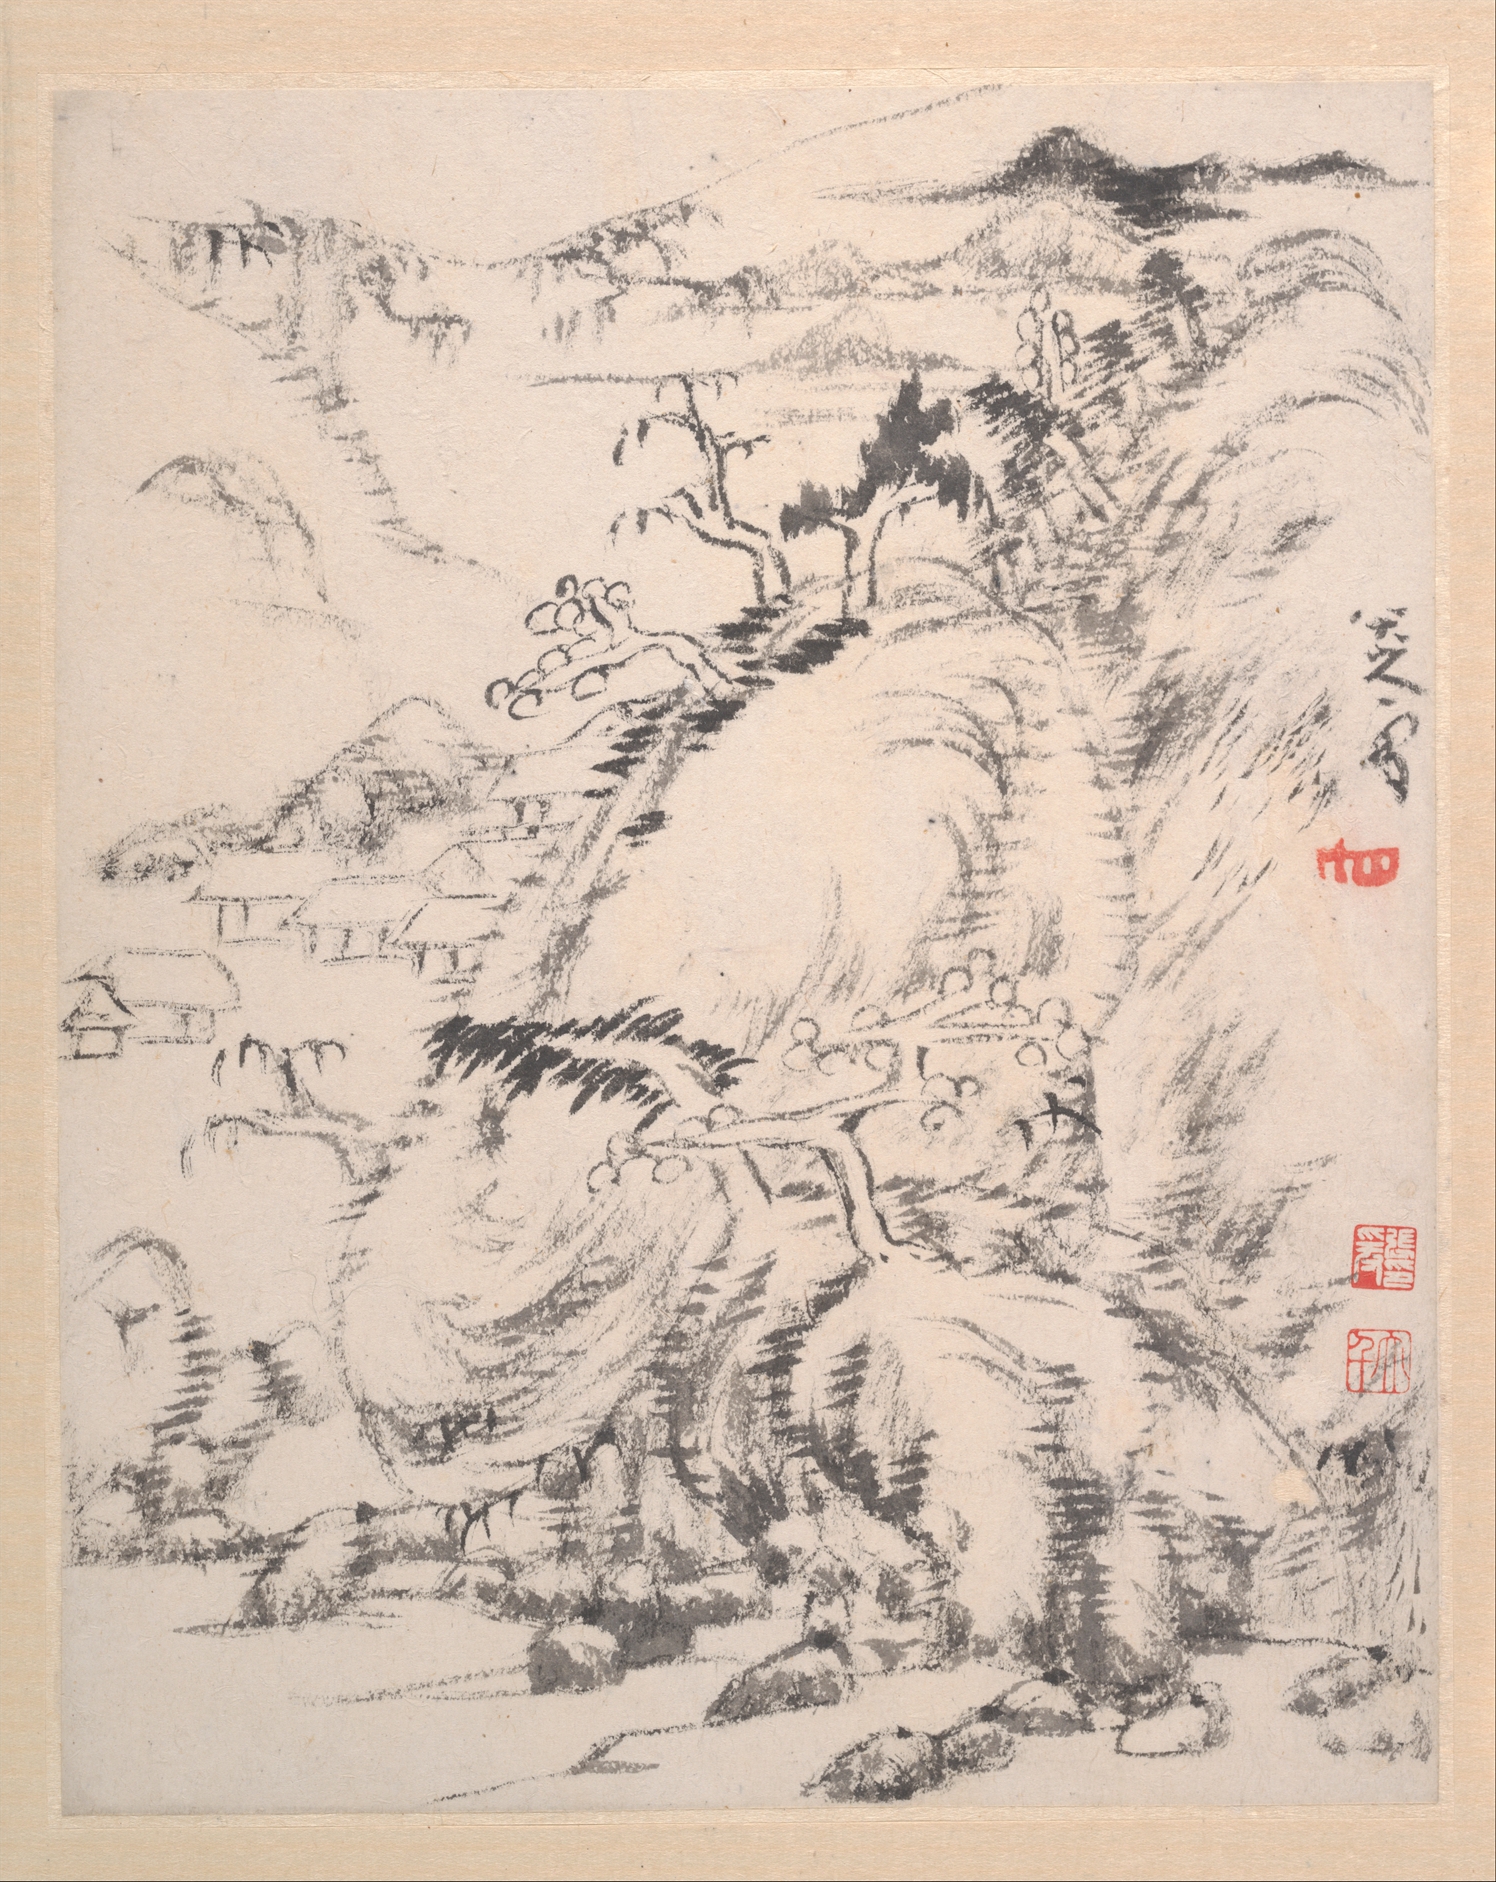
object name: album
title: Landscape album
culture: chinese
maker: bada shanren (zhu da)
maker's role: artist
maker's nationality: chinese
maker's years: 1626-1705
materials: ink, paper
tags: mountains,landscapes